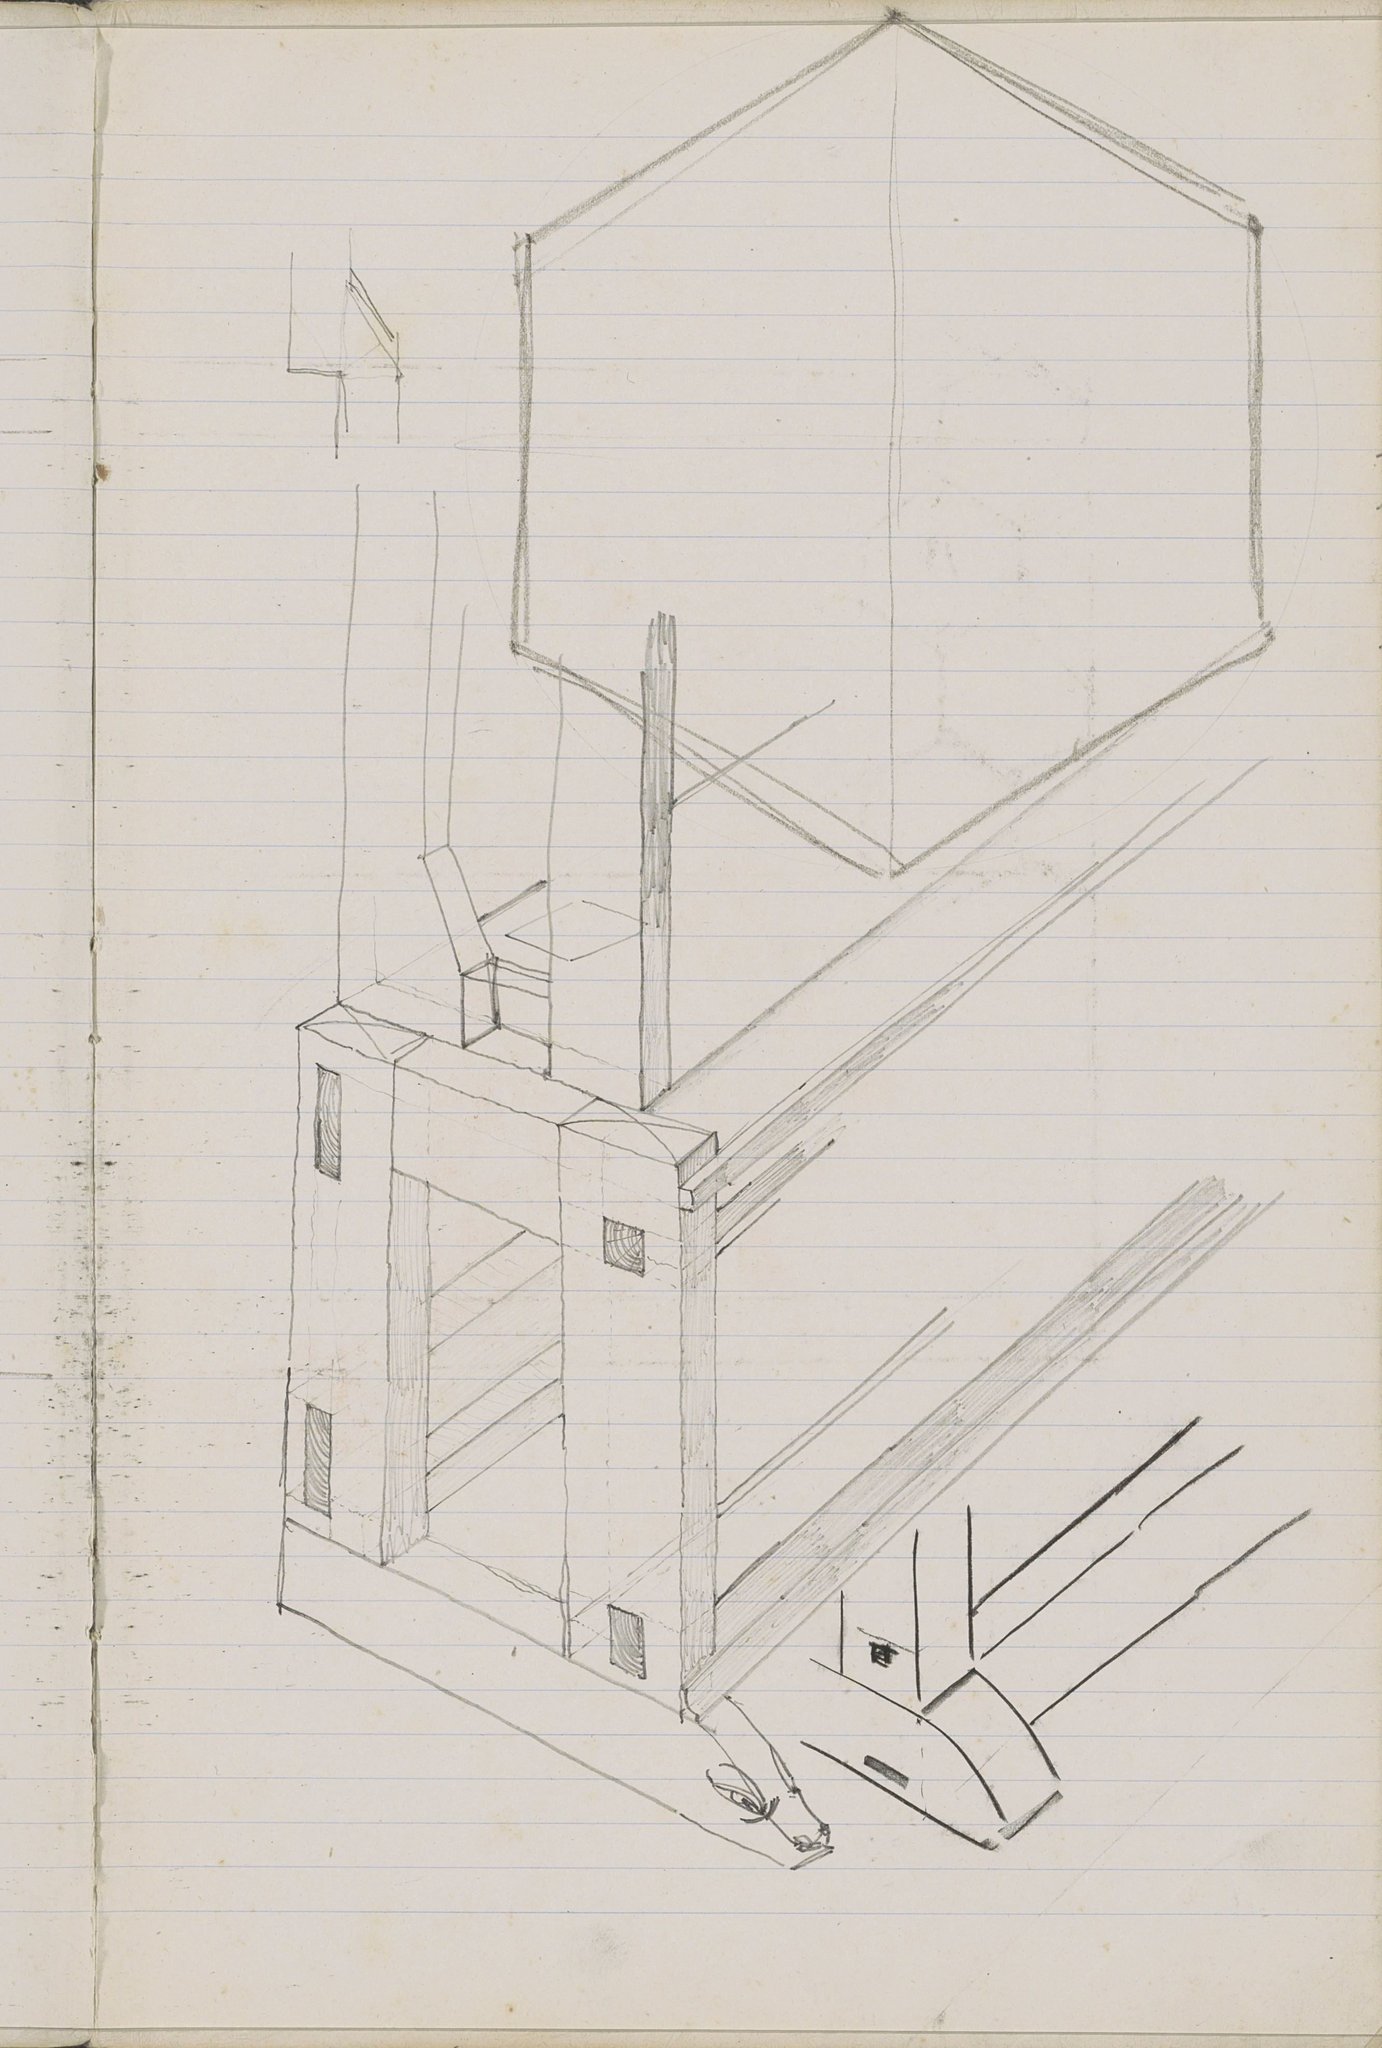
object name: sketchbook leaf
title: Meubelontwerp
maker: gerrit willem dijsselhof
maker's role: designer, draughtsman, print maker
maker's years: 1866-1924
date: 1901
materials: chalk, pencil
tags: design, plan (~ production), flowers ~ ornament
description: Blad 3 recto uit een schetsboek met 79 bladen.